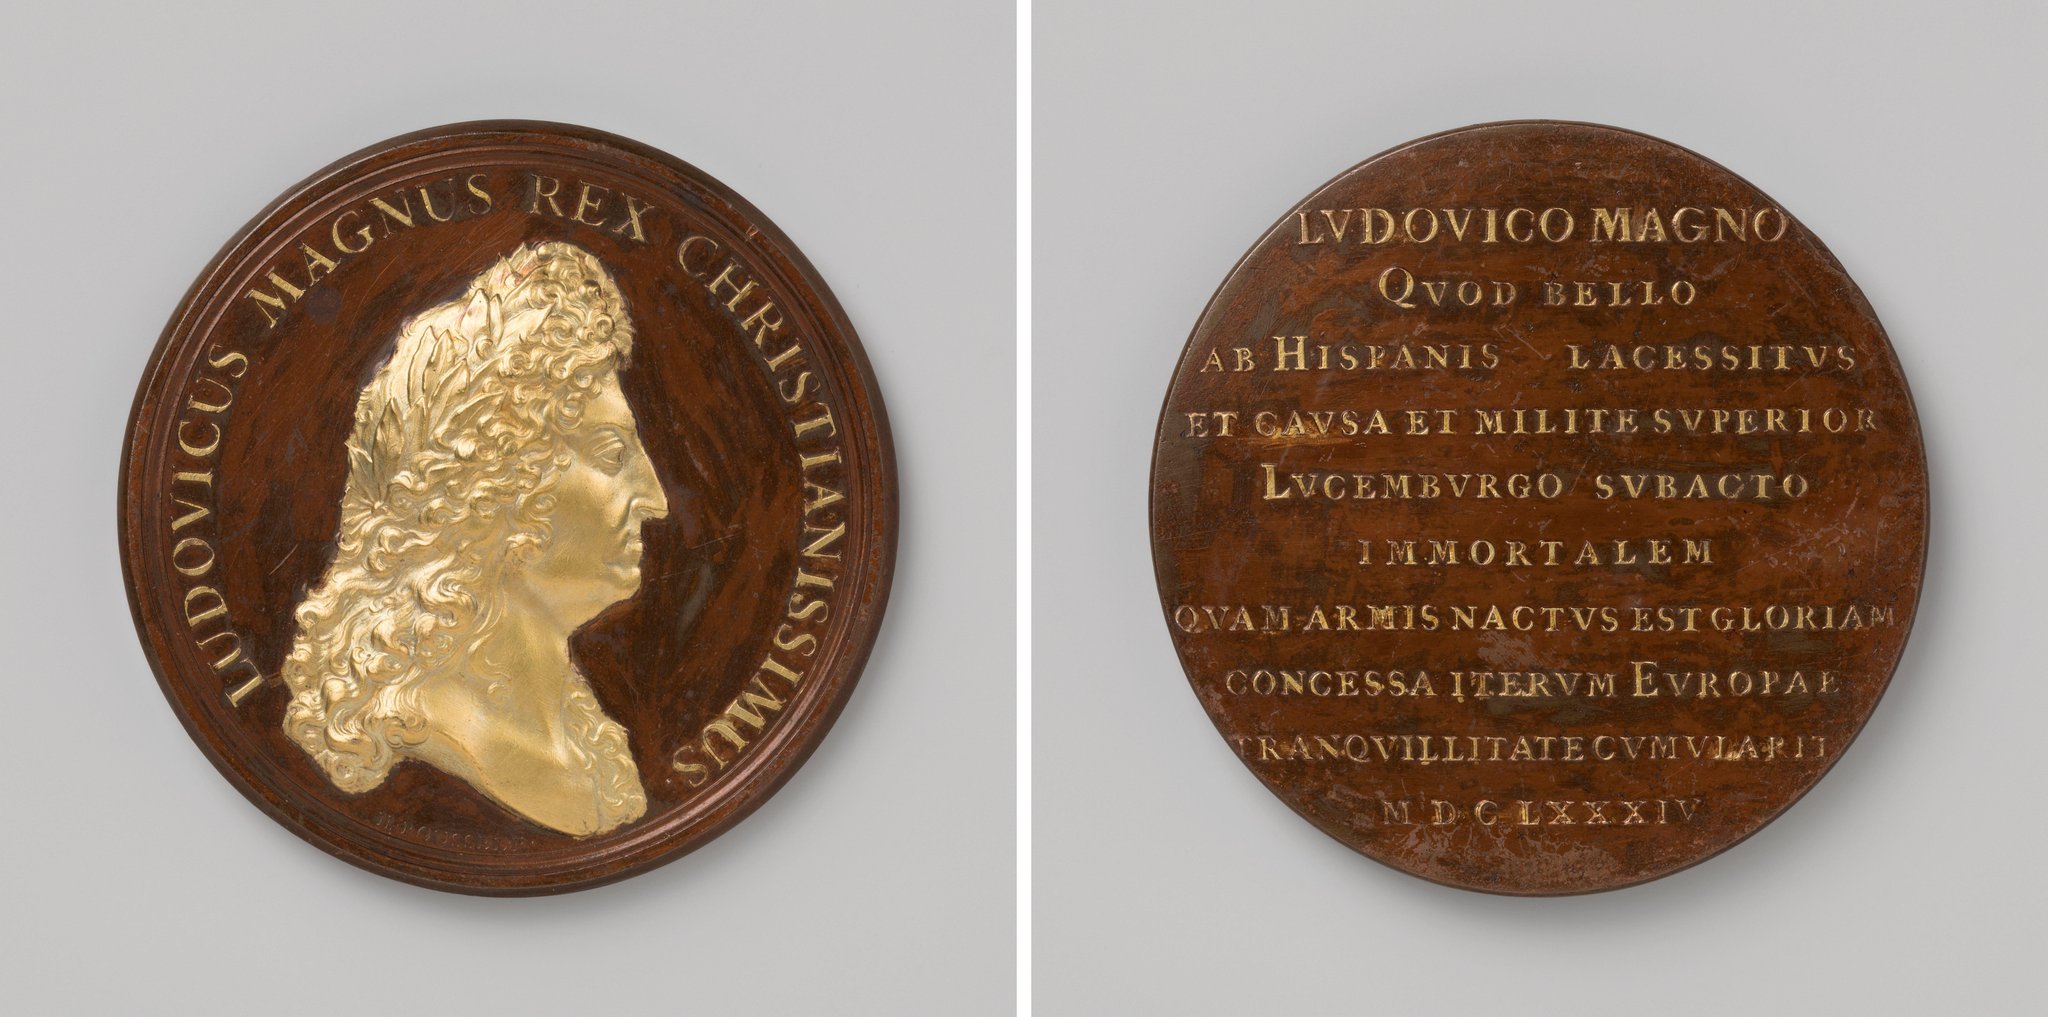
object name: history medal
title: Twintigjarige bestand van Regensburg tussen Frankrijk, de Keizer, Spanje en de Nederlanden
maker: jérôme roussel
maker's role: medailleur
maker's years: 1663-1713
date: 1684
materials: bronze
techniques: gilding, striking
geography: paris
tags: lodewijk xiv (koning van frankrijk)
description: Bronzen penning. Voorzijde: borststuk man met lauwerkrans binnen omschrift. Keerzijde: opschrift